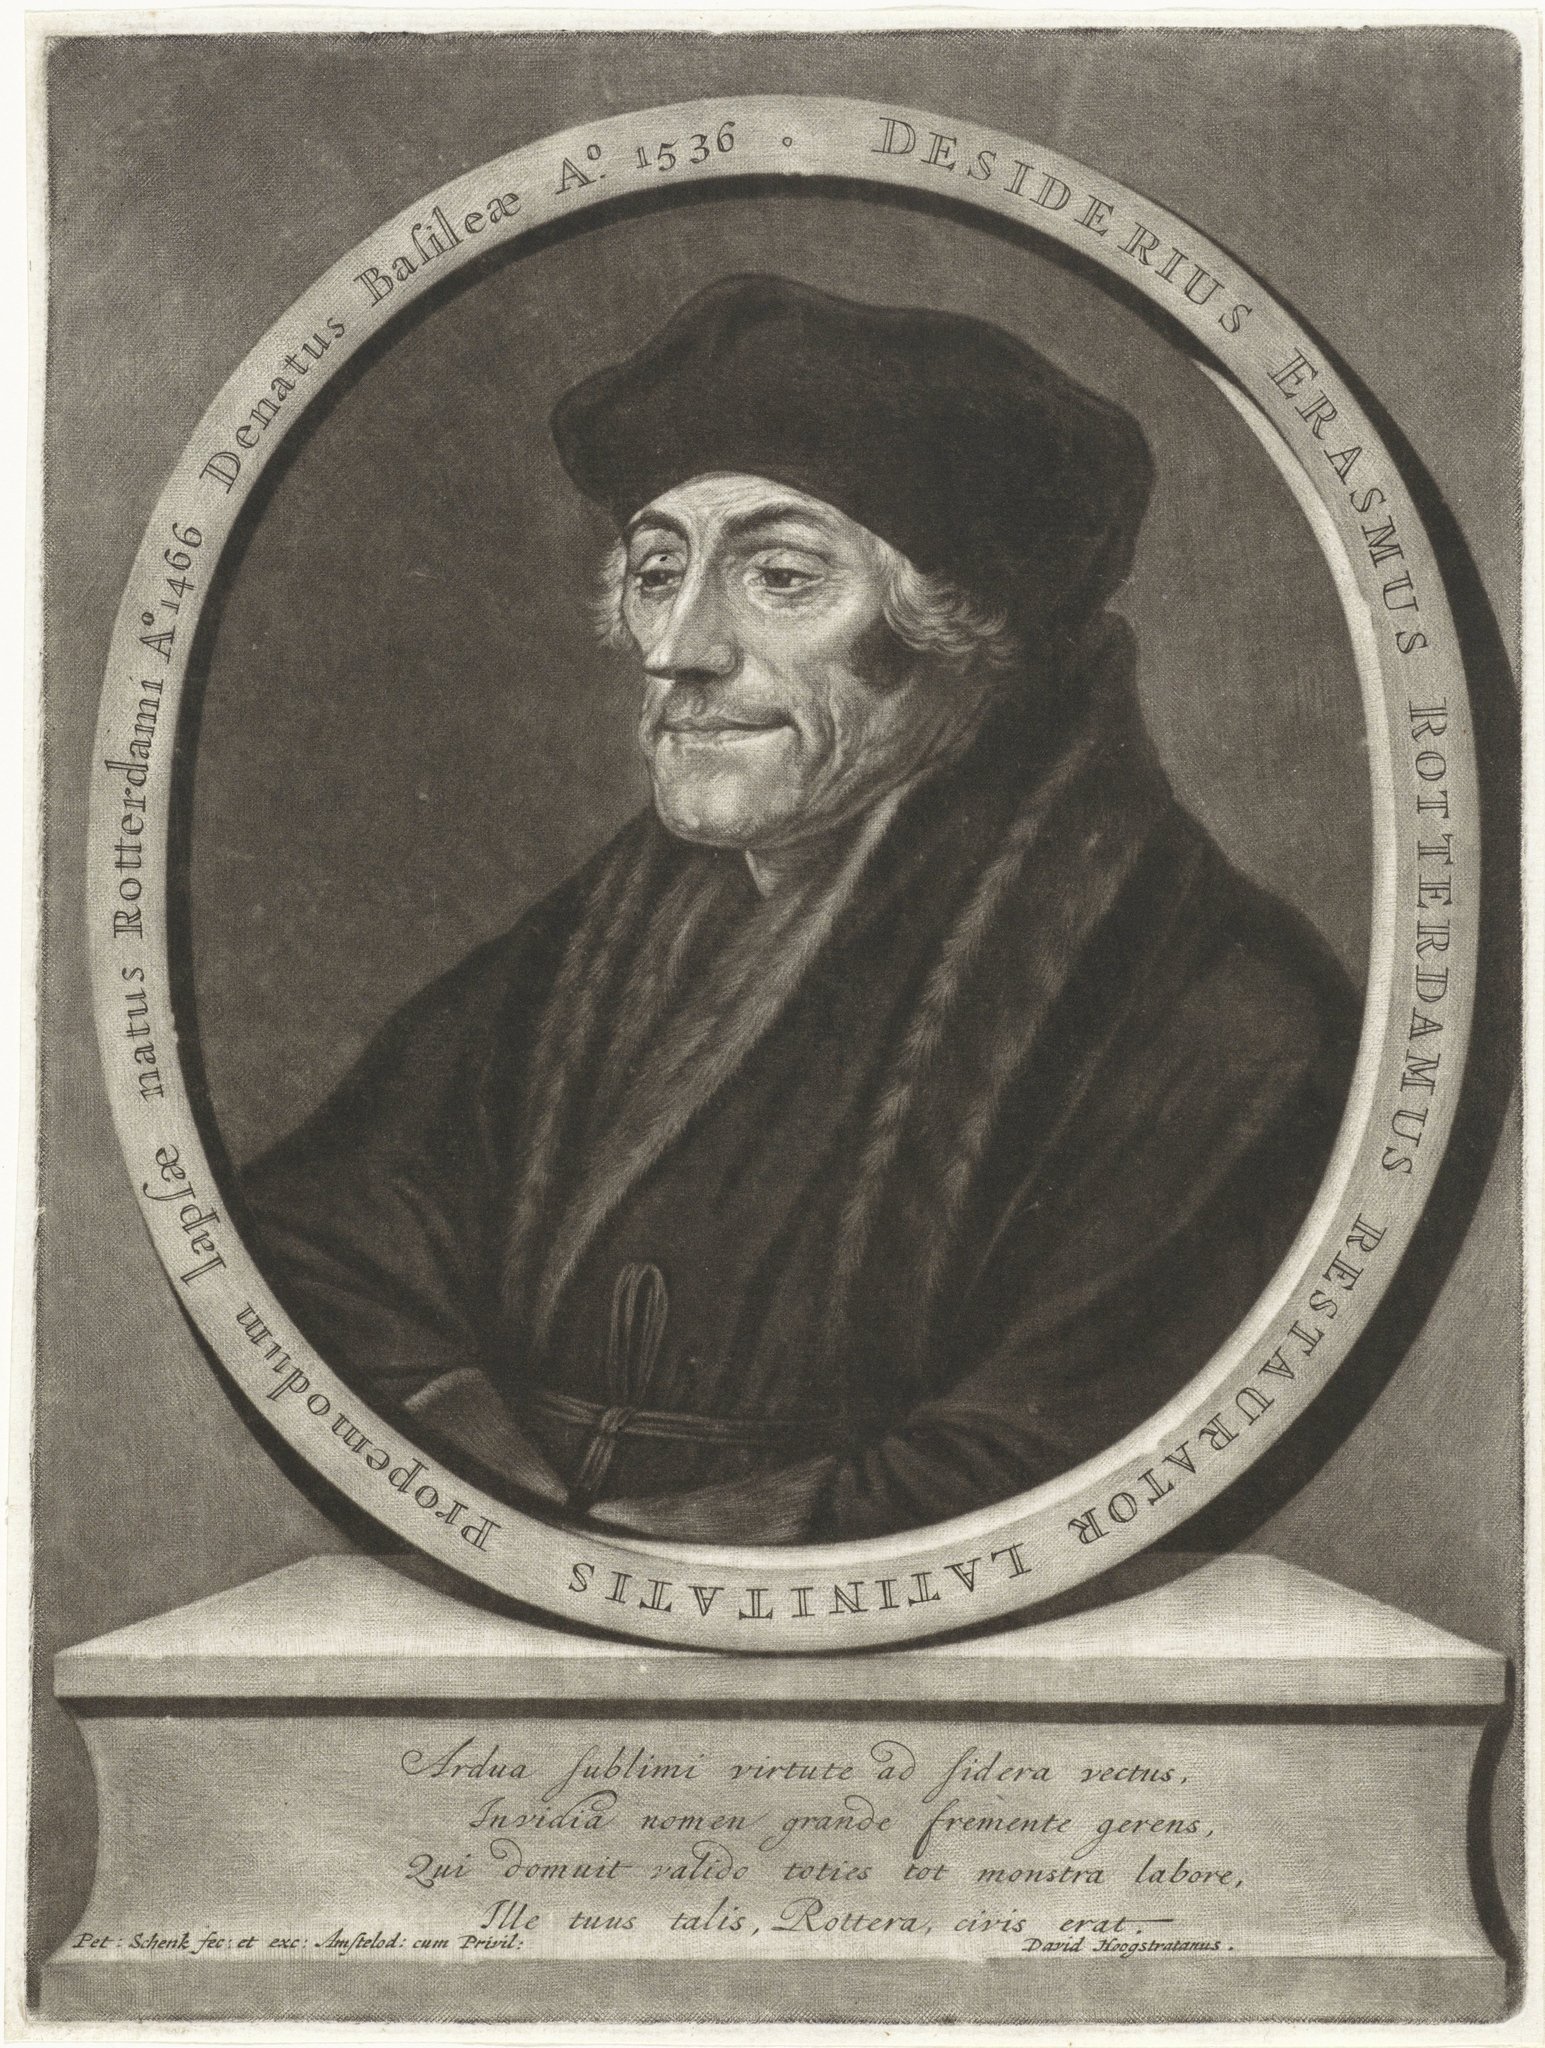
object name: print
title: Portret van Desiderius Erasmus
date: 1670-1713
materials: paper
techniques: engraving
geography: amsterdam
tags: rotterdam, desiderius erasmus, historical persons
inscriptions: collector's mark: Lugt 240